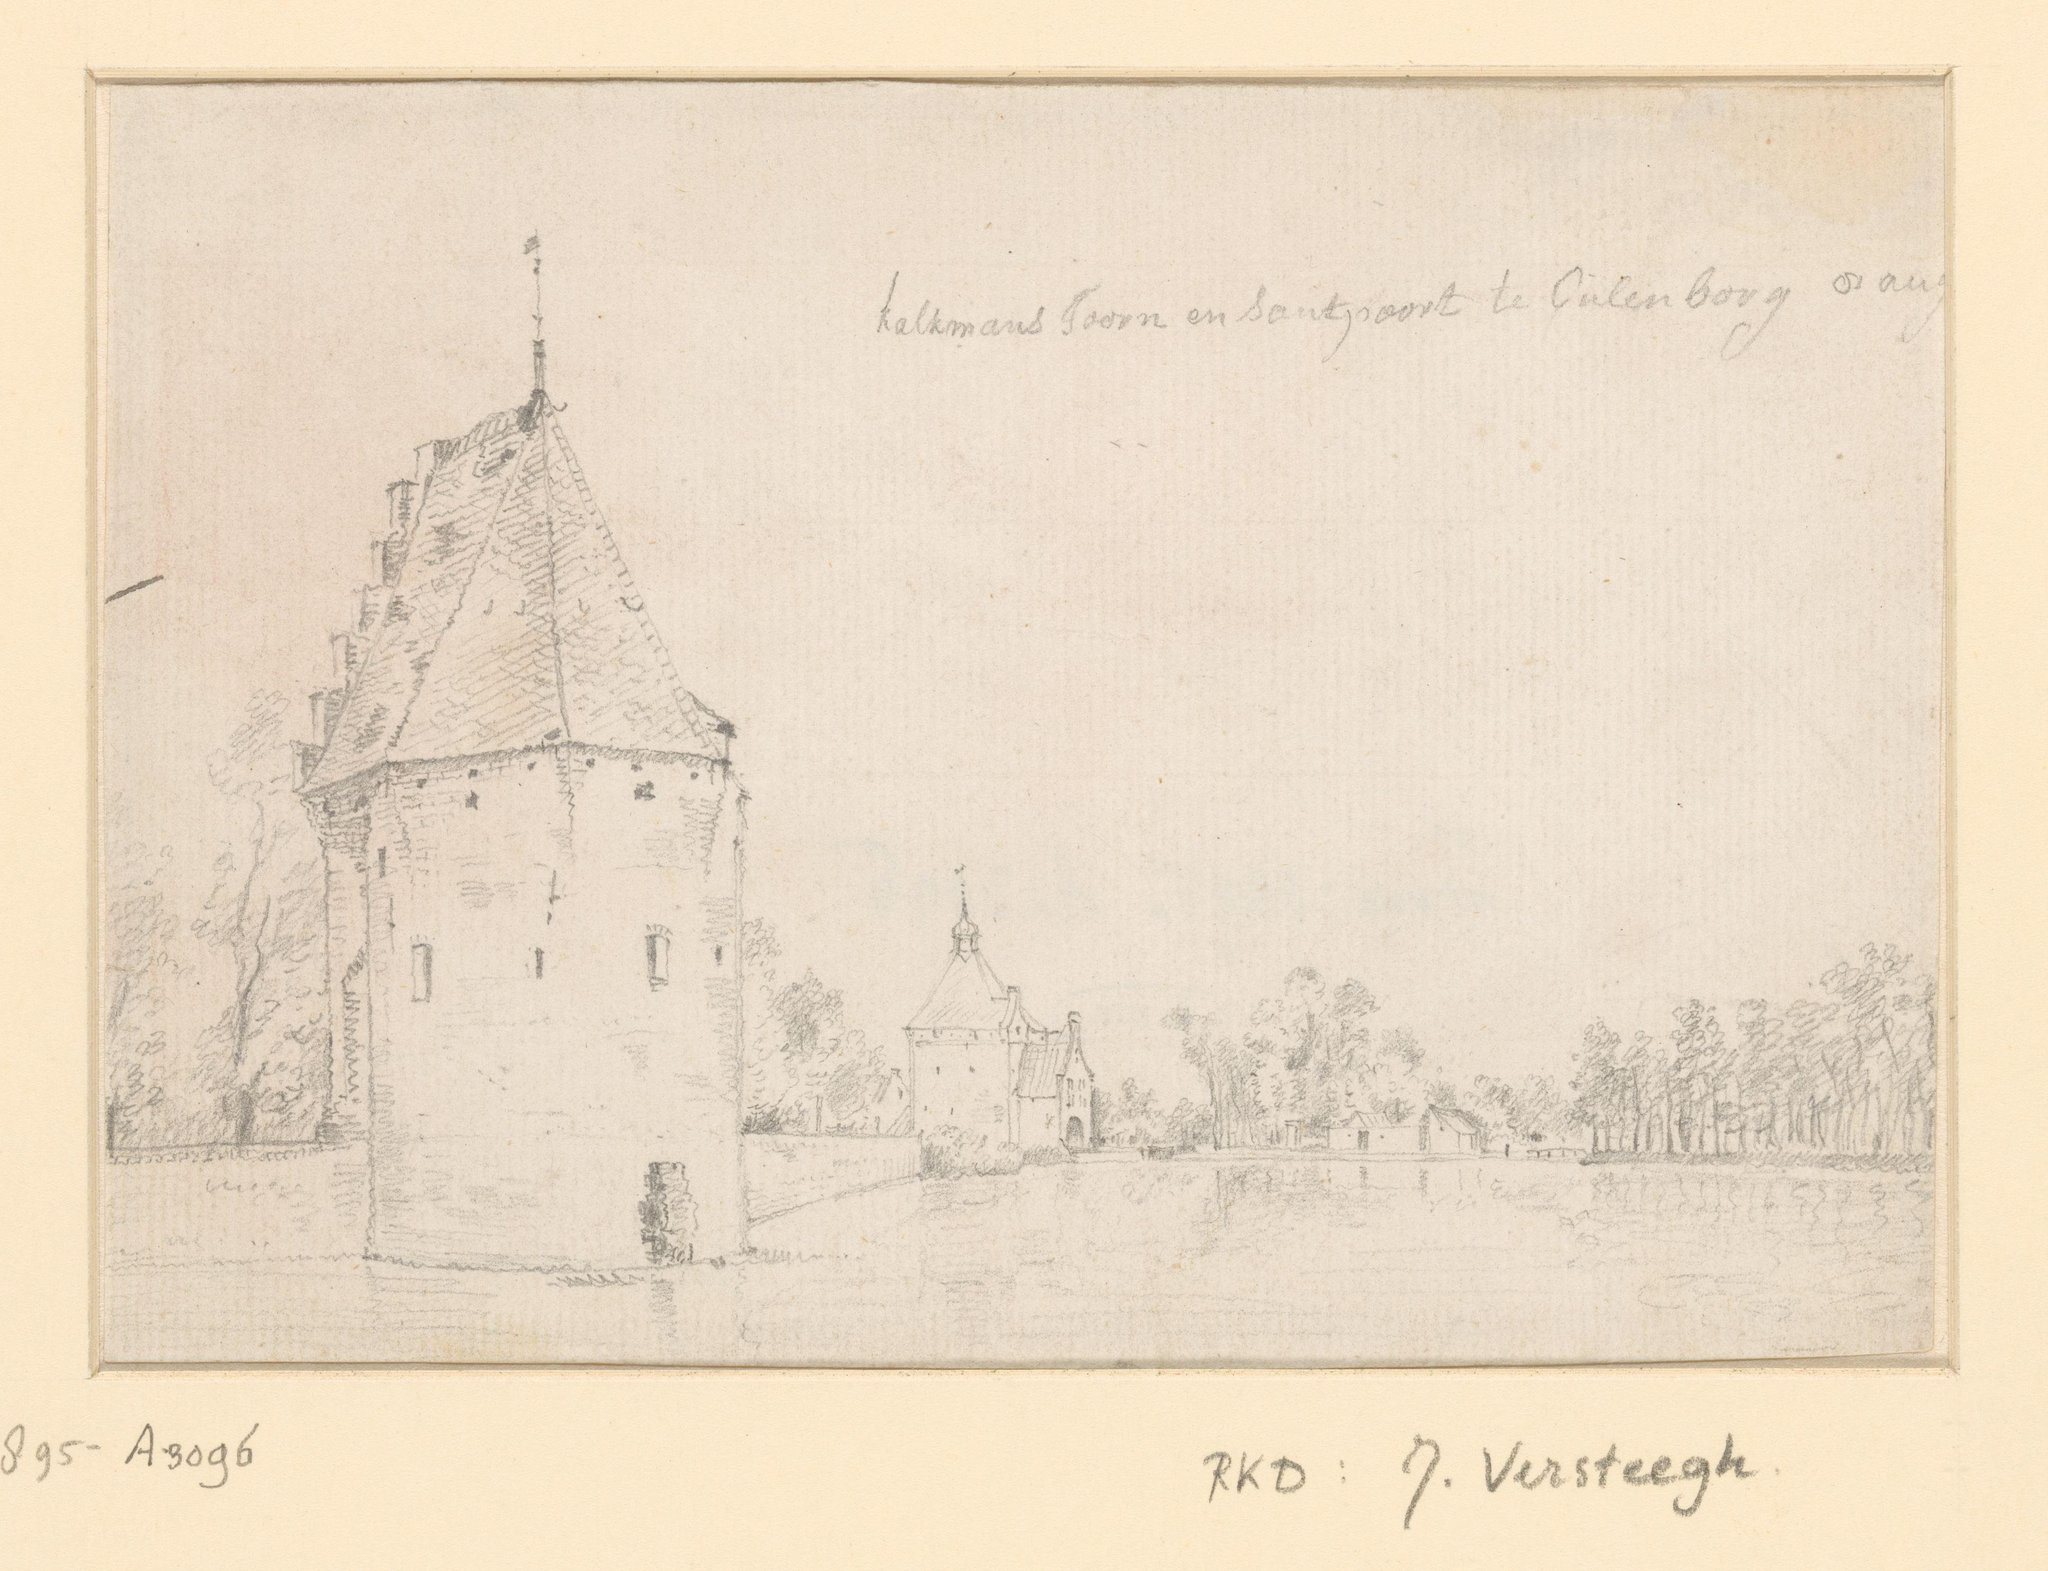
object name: drawing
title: Kalkmans Toorn en Santpoort te Culemborg 8 aug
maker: Anonymous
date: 1750-1800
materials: paper, pencil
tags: landscape with tower or castle, city-gate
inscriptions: collector's mark: Lugt 2228